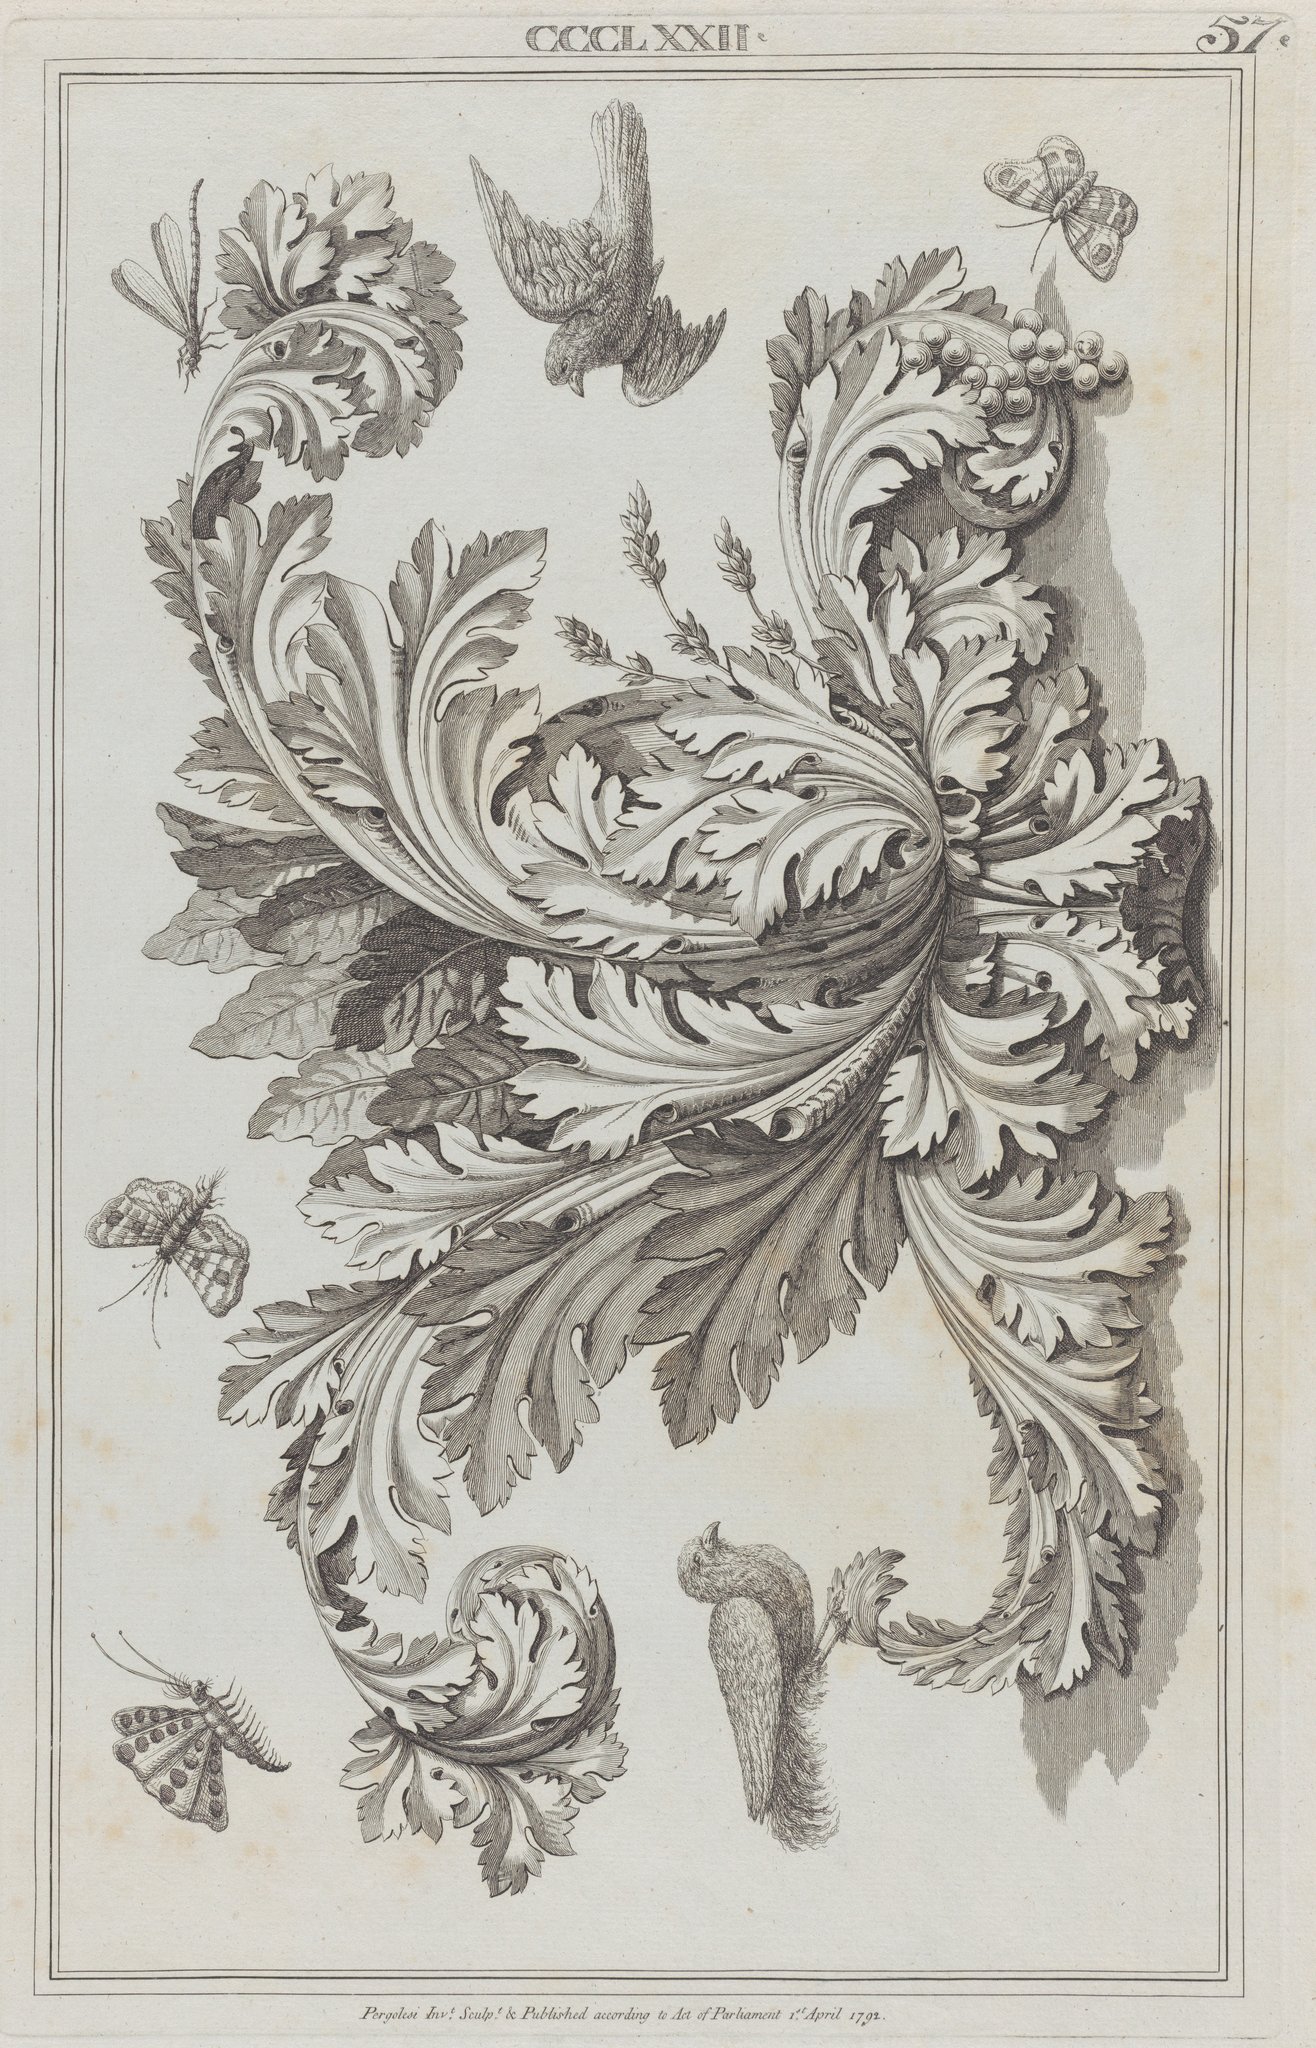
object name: print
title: Acanthus Leaves, Birds and Insects, no. CCCLXXII, plate 57 from "Designs for Various Ornaments"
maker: michelangelo pergolesi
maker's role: artist and publisher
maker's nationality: italian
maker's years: 1760-1801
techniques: engraving, etching